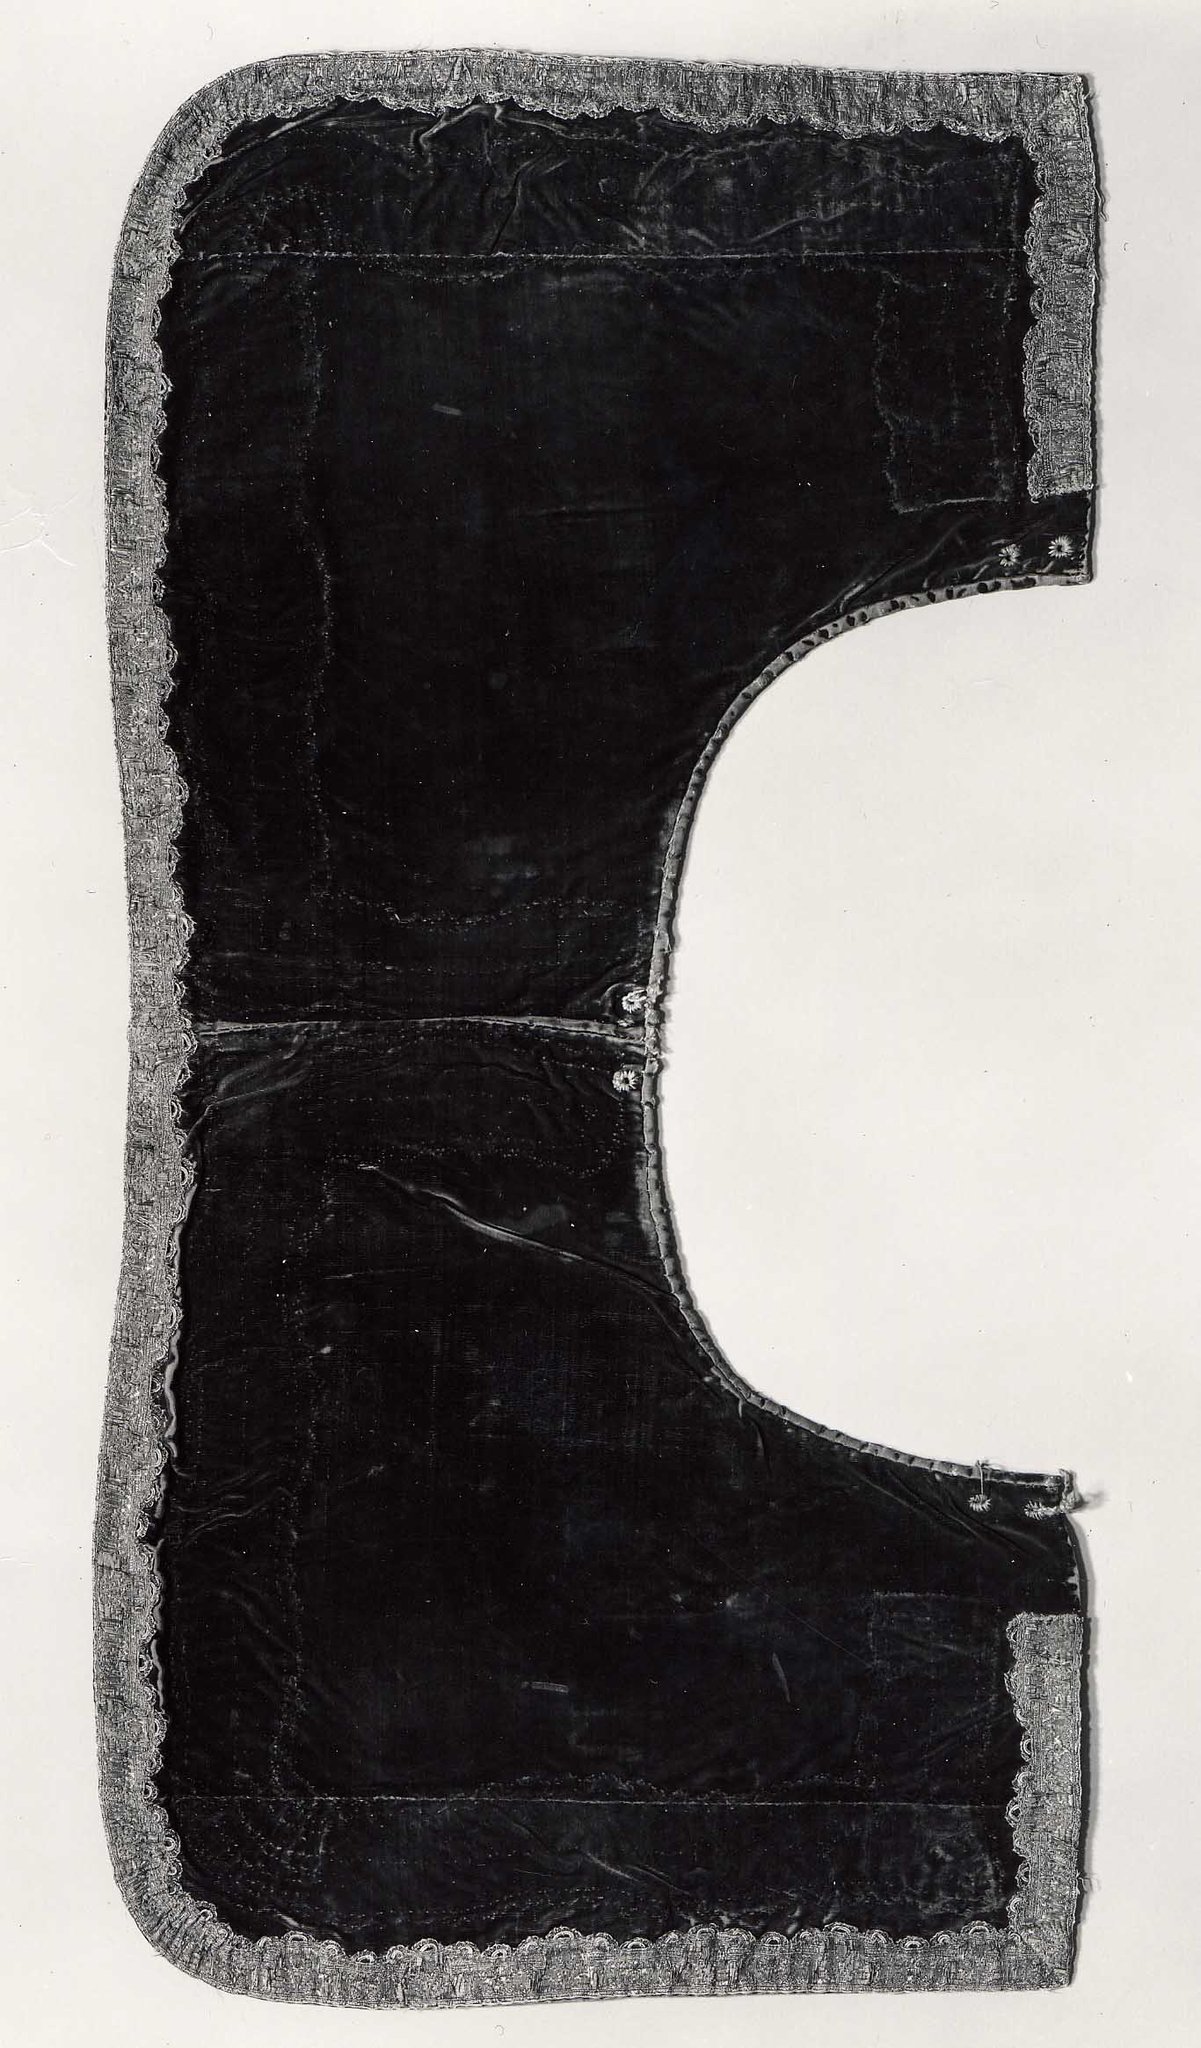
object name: saddle cloth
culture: italian or spanish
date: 1601-1800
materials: leather, metal, silk